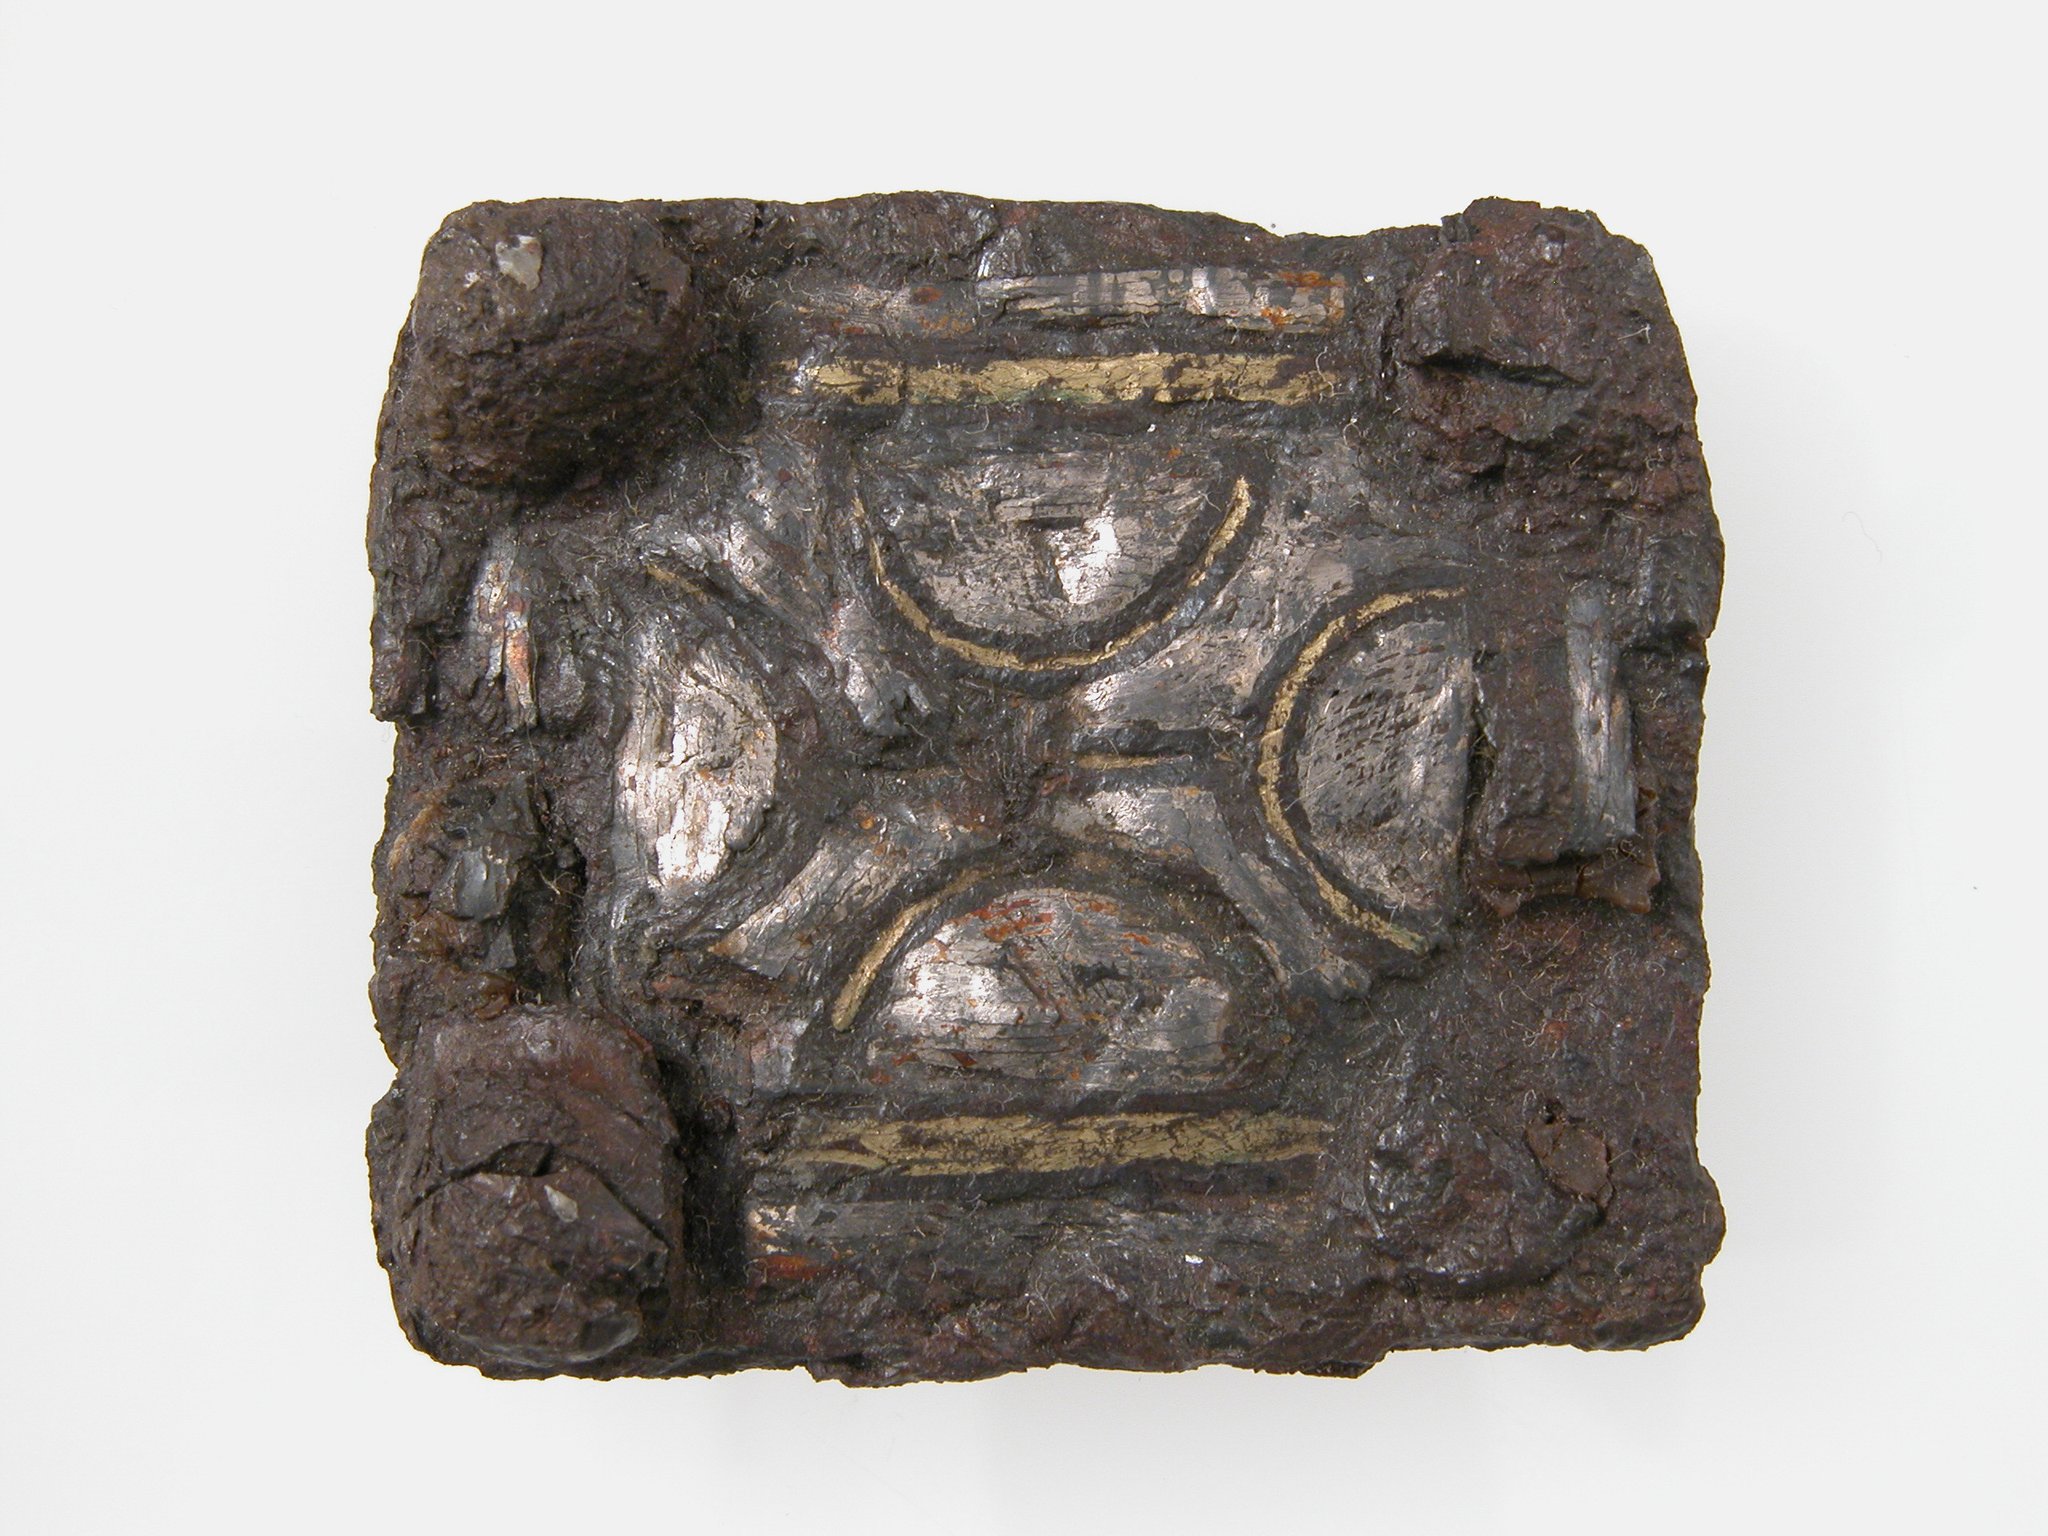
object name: belt plate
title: Backplate of a Belt Buckle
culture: frankish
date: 501-700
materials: brass, iron, silver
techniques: inlay